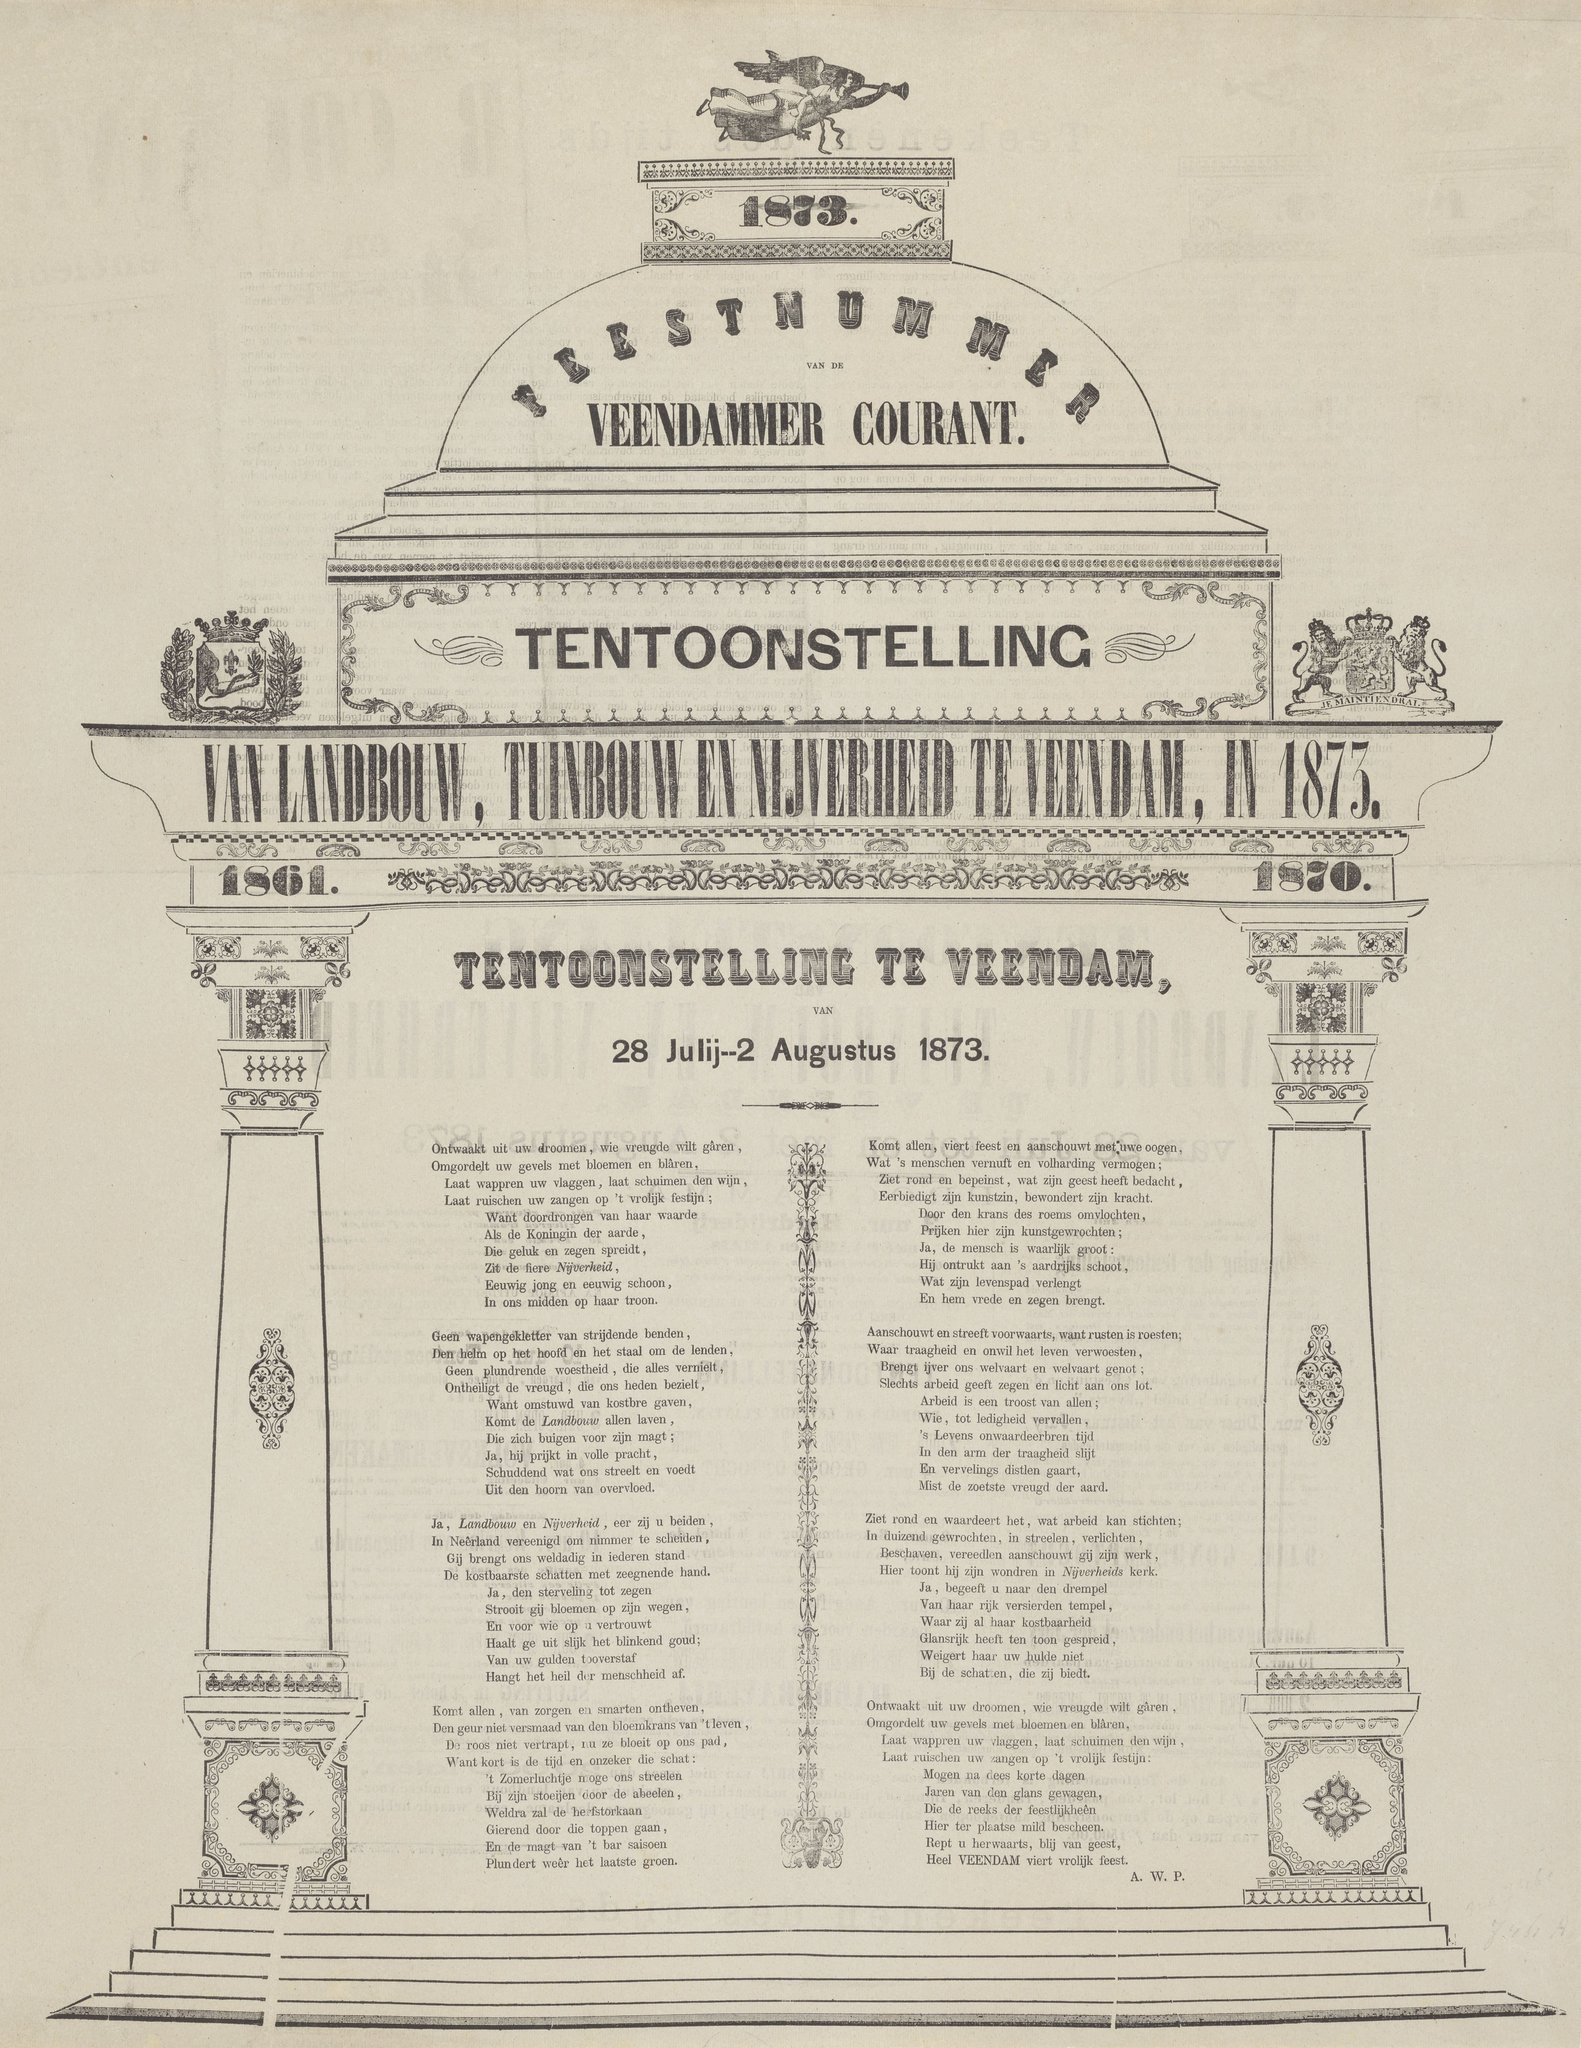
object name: print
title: Feestnummer van de Veendammer Courant. Tentoonstelling van Landbouw, Tuinbouw en Nijverheid te Veendam, in 1873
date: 1873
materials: paper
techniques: letterpress printing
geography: netherlands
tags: trade exhibition, industries fair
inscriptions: collector's mark: Lugt 2228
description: Feestnummer van de Veendammer Courant ter gelegenheid van de landbouw-, tuinbouw- en nijverheidtentoonstelling gehouden te Veendam van 28 juli tot 2 augustus 1873. Façade van een tempel met twee zuilen waarbinnen een gedicht in acht verzen in twee kolommen. Blad bedrukt op beide zijden, op de achterzijde een tekst en het programma.